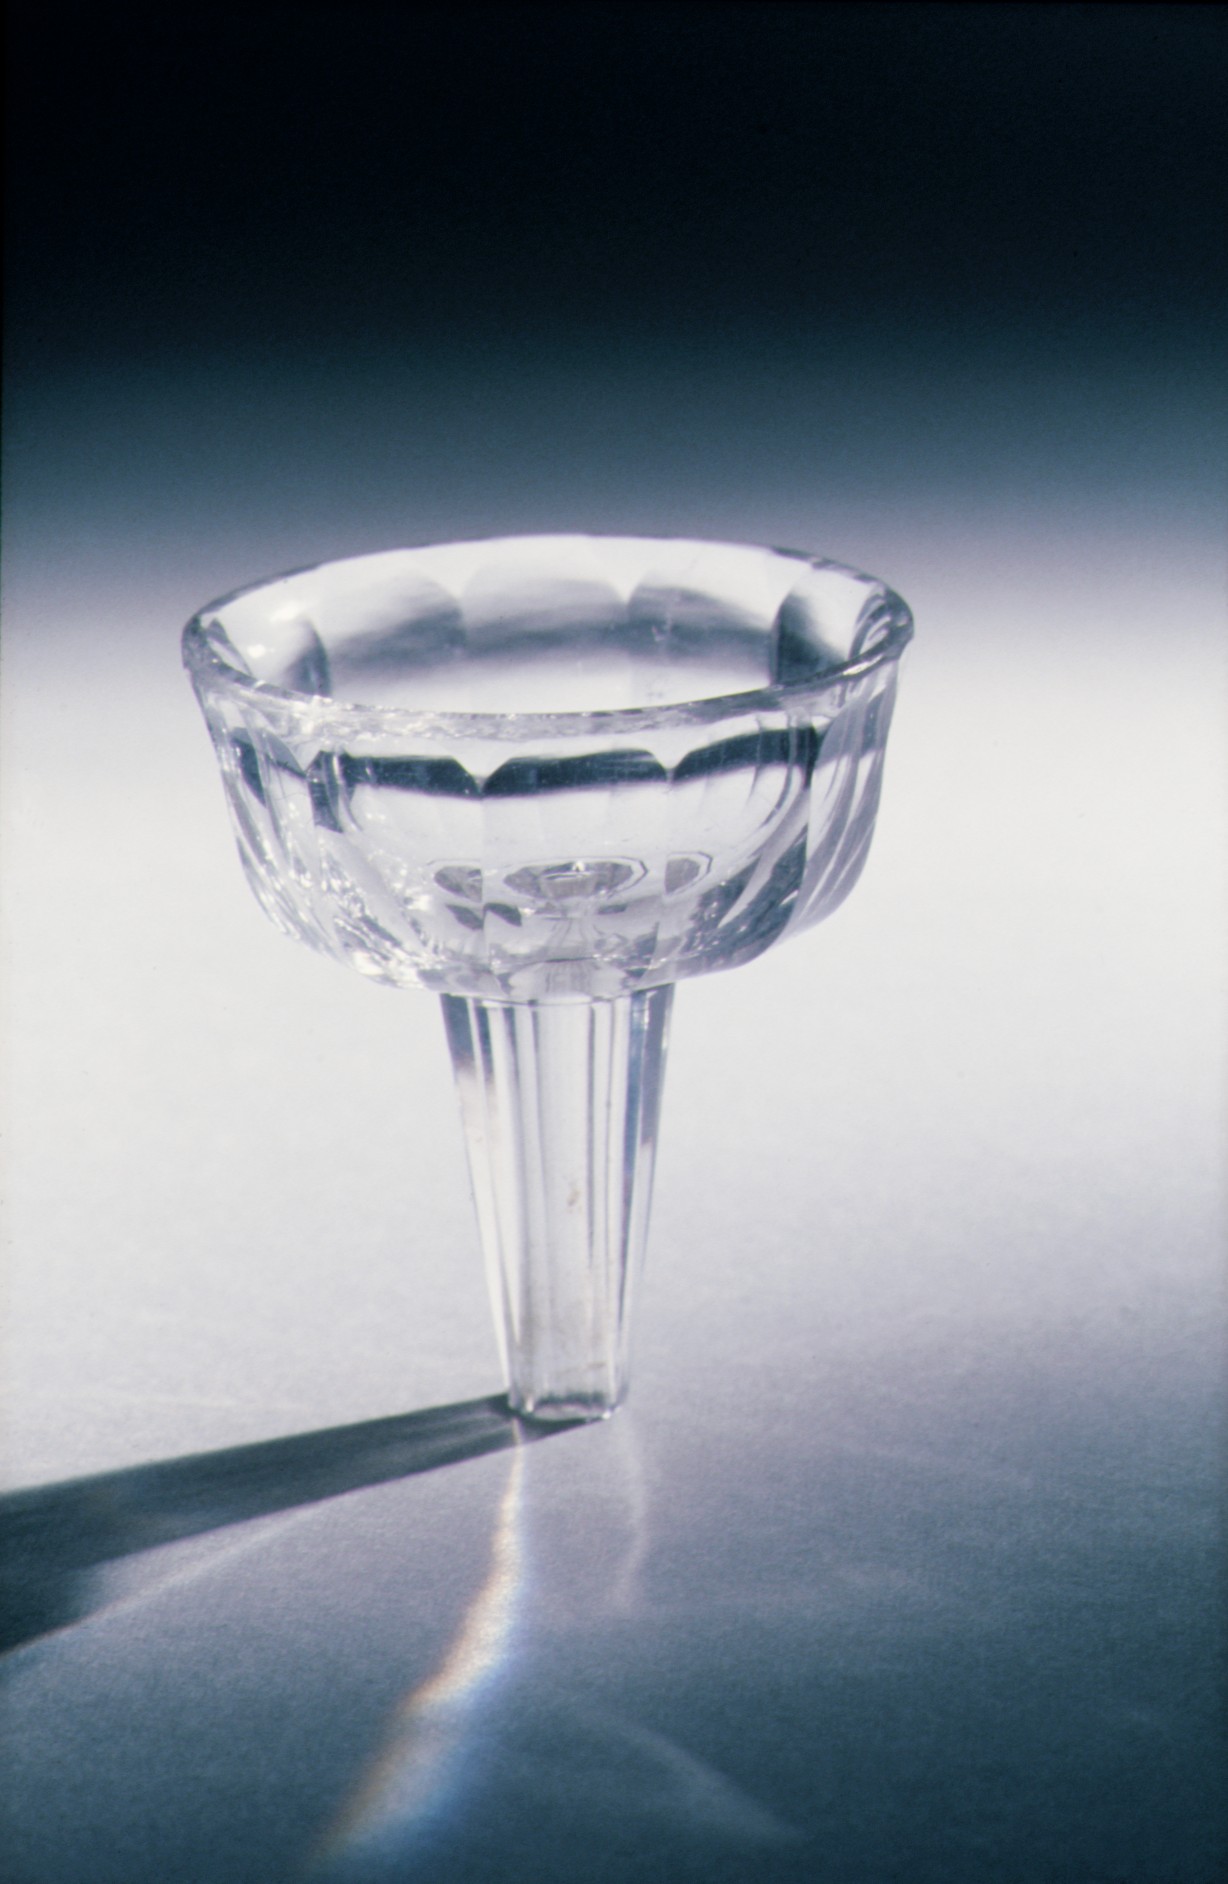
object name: funnel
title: Funnel (part of a set)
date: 1728-1730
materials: quartz